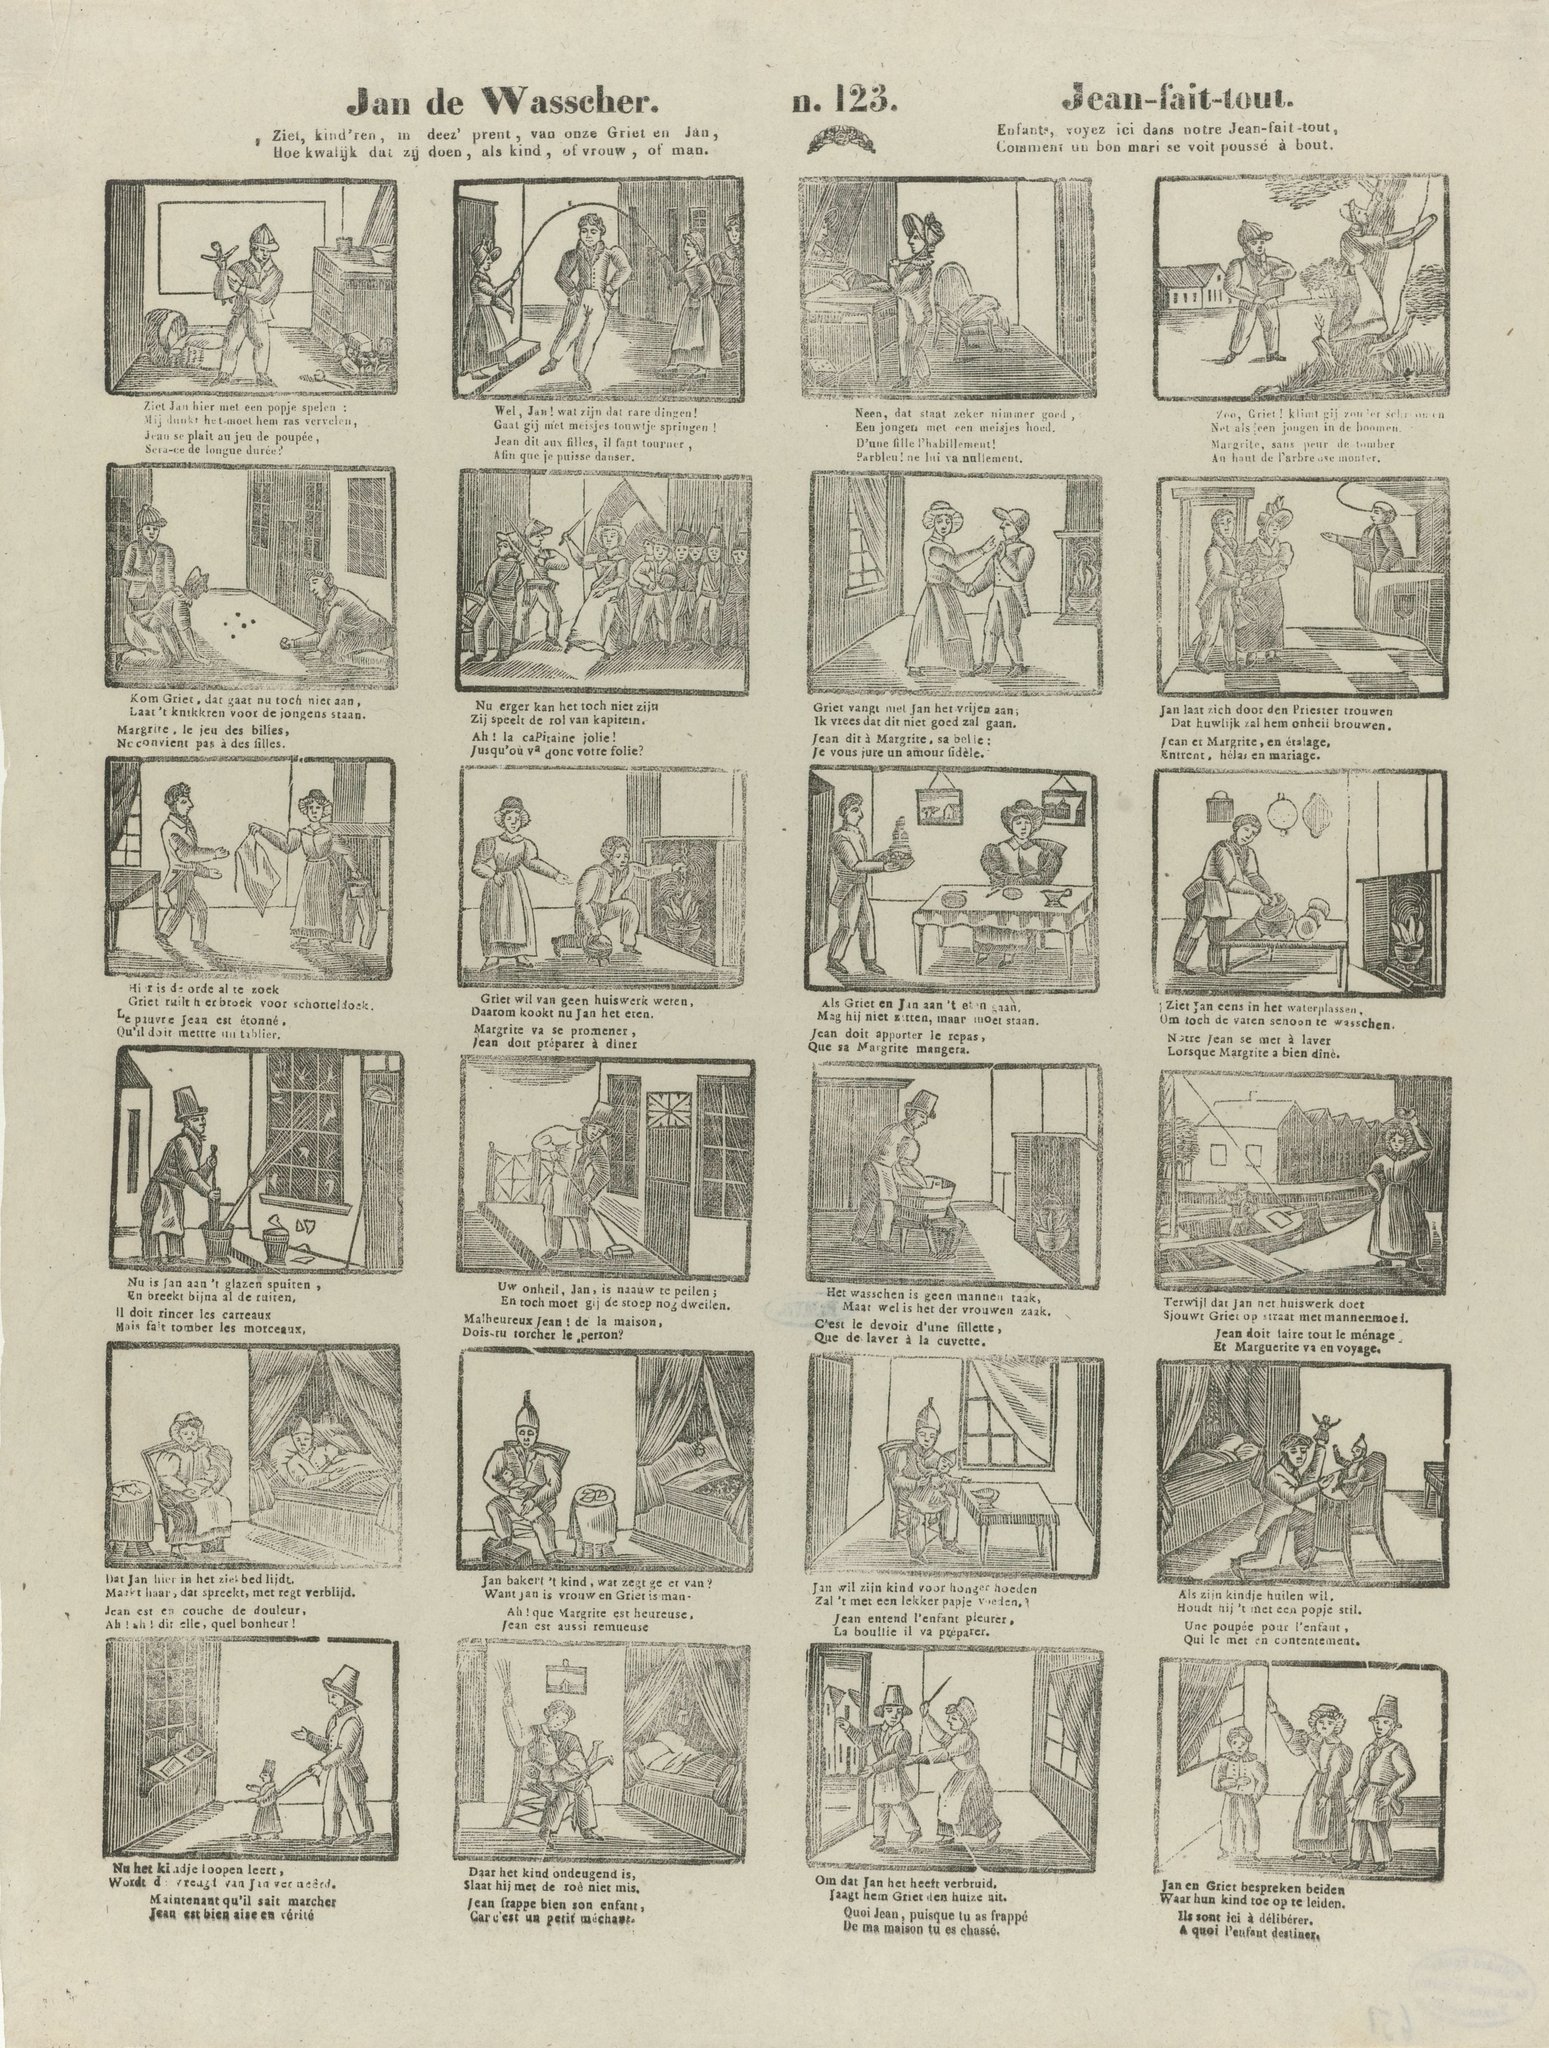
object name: print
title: Jan de Wasscher / Jean-fait-tout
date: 1800-1833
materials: paper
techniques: letterpress printing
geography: turnhout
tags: hen-pecked husband, 'betty', 'molly' (man who engages in women's work)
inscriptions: collector's mark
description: Blad met 24 voorstellingen uit het leven van Jan de Wasser, een man die van zijn vrouw Griet, die de broek aan heeft, al het huishoudelijk werk moet doen. Onder elke voorstelling een tweeregelig vers in het Nederlands en in het Frans. Genummerd midden boven: n. 123.